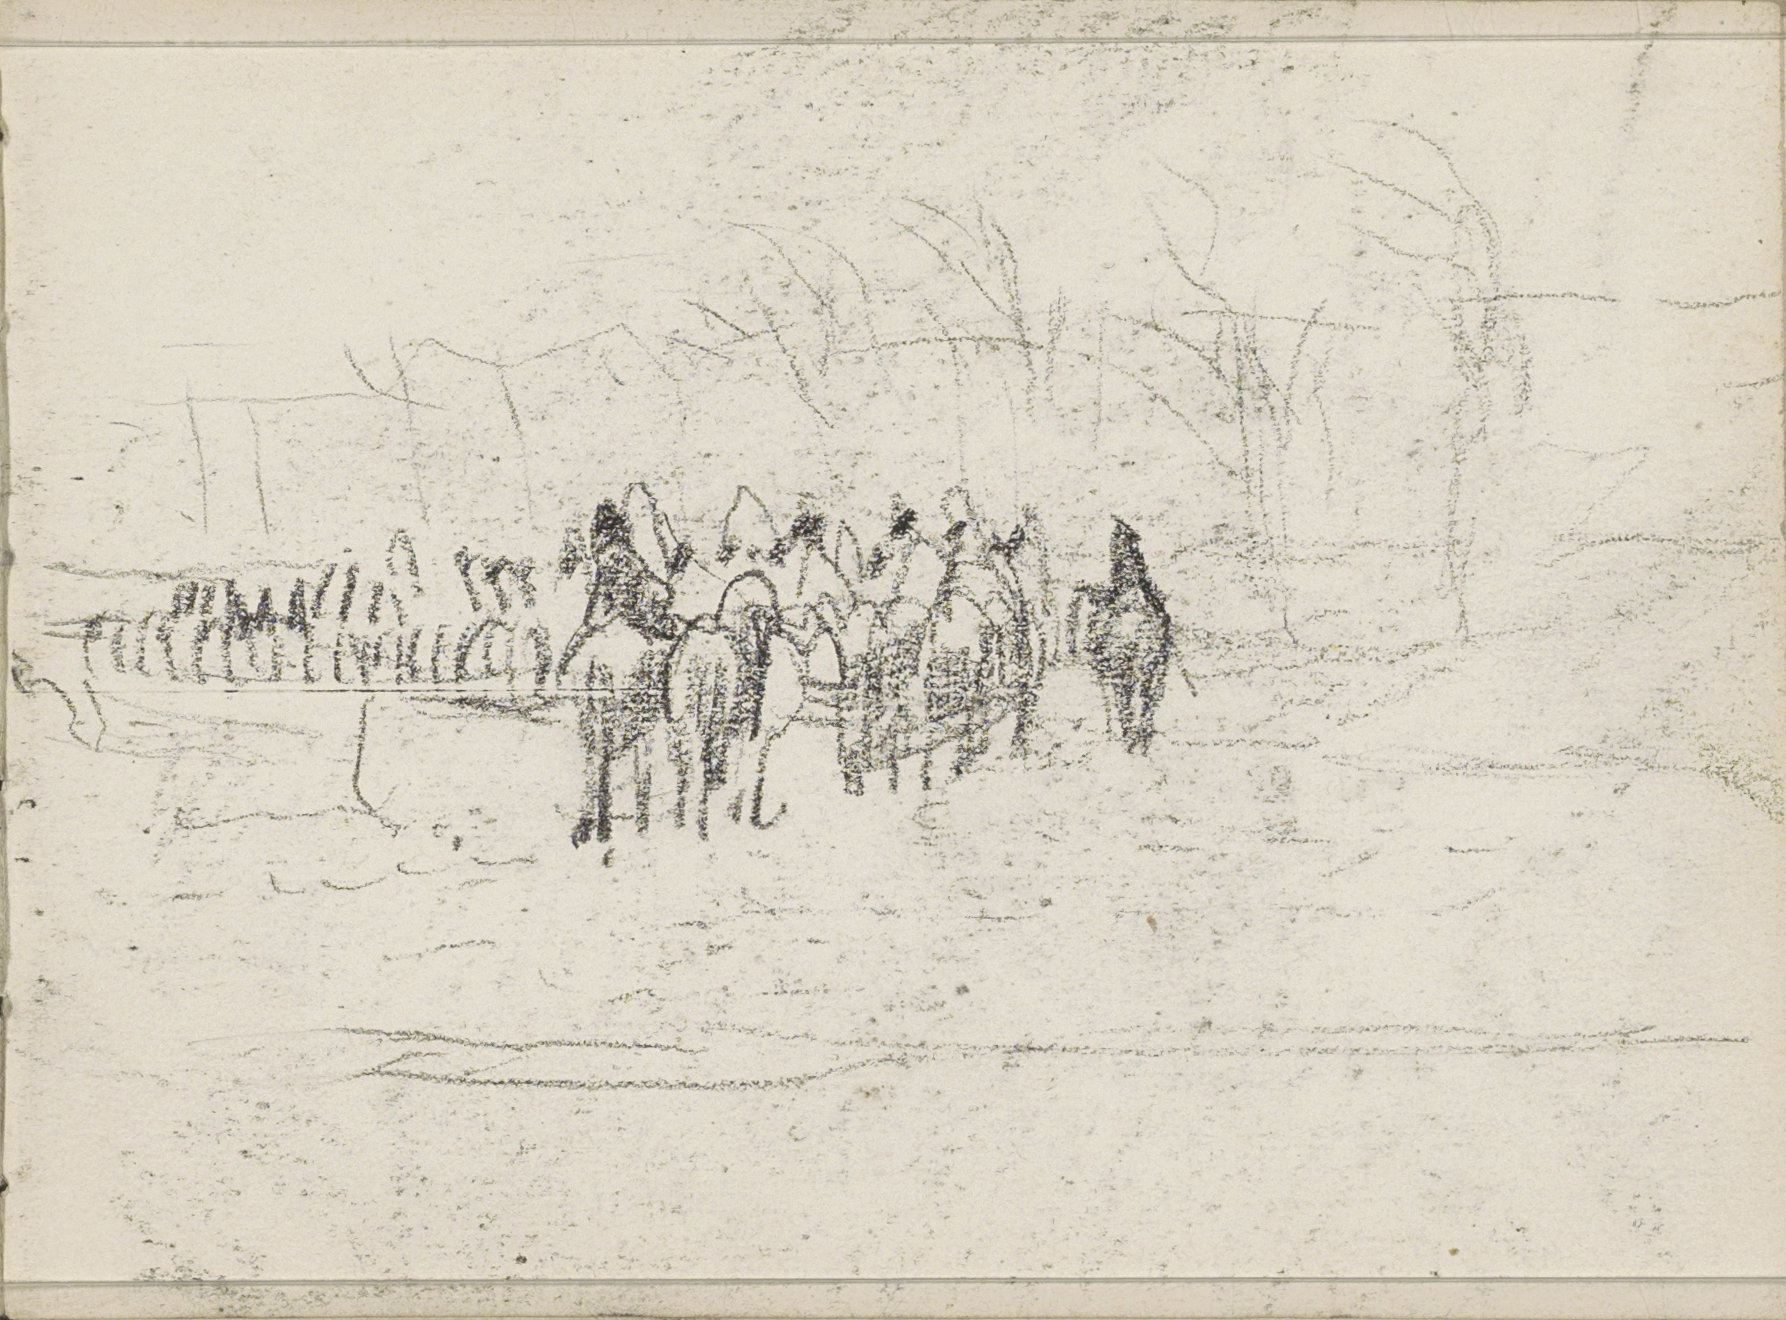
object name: sketchbook leaf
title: Groep ruiters op een pad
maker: anton mauve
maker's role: draughtsman, painter, print maker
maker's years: 1838-1888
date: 1848-1888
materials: chalk, paper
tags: riding a horse, ass, or mule; rider, horseman, road, path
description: Blad 11 recto uit een schetsboek met 33 bladen.